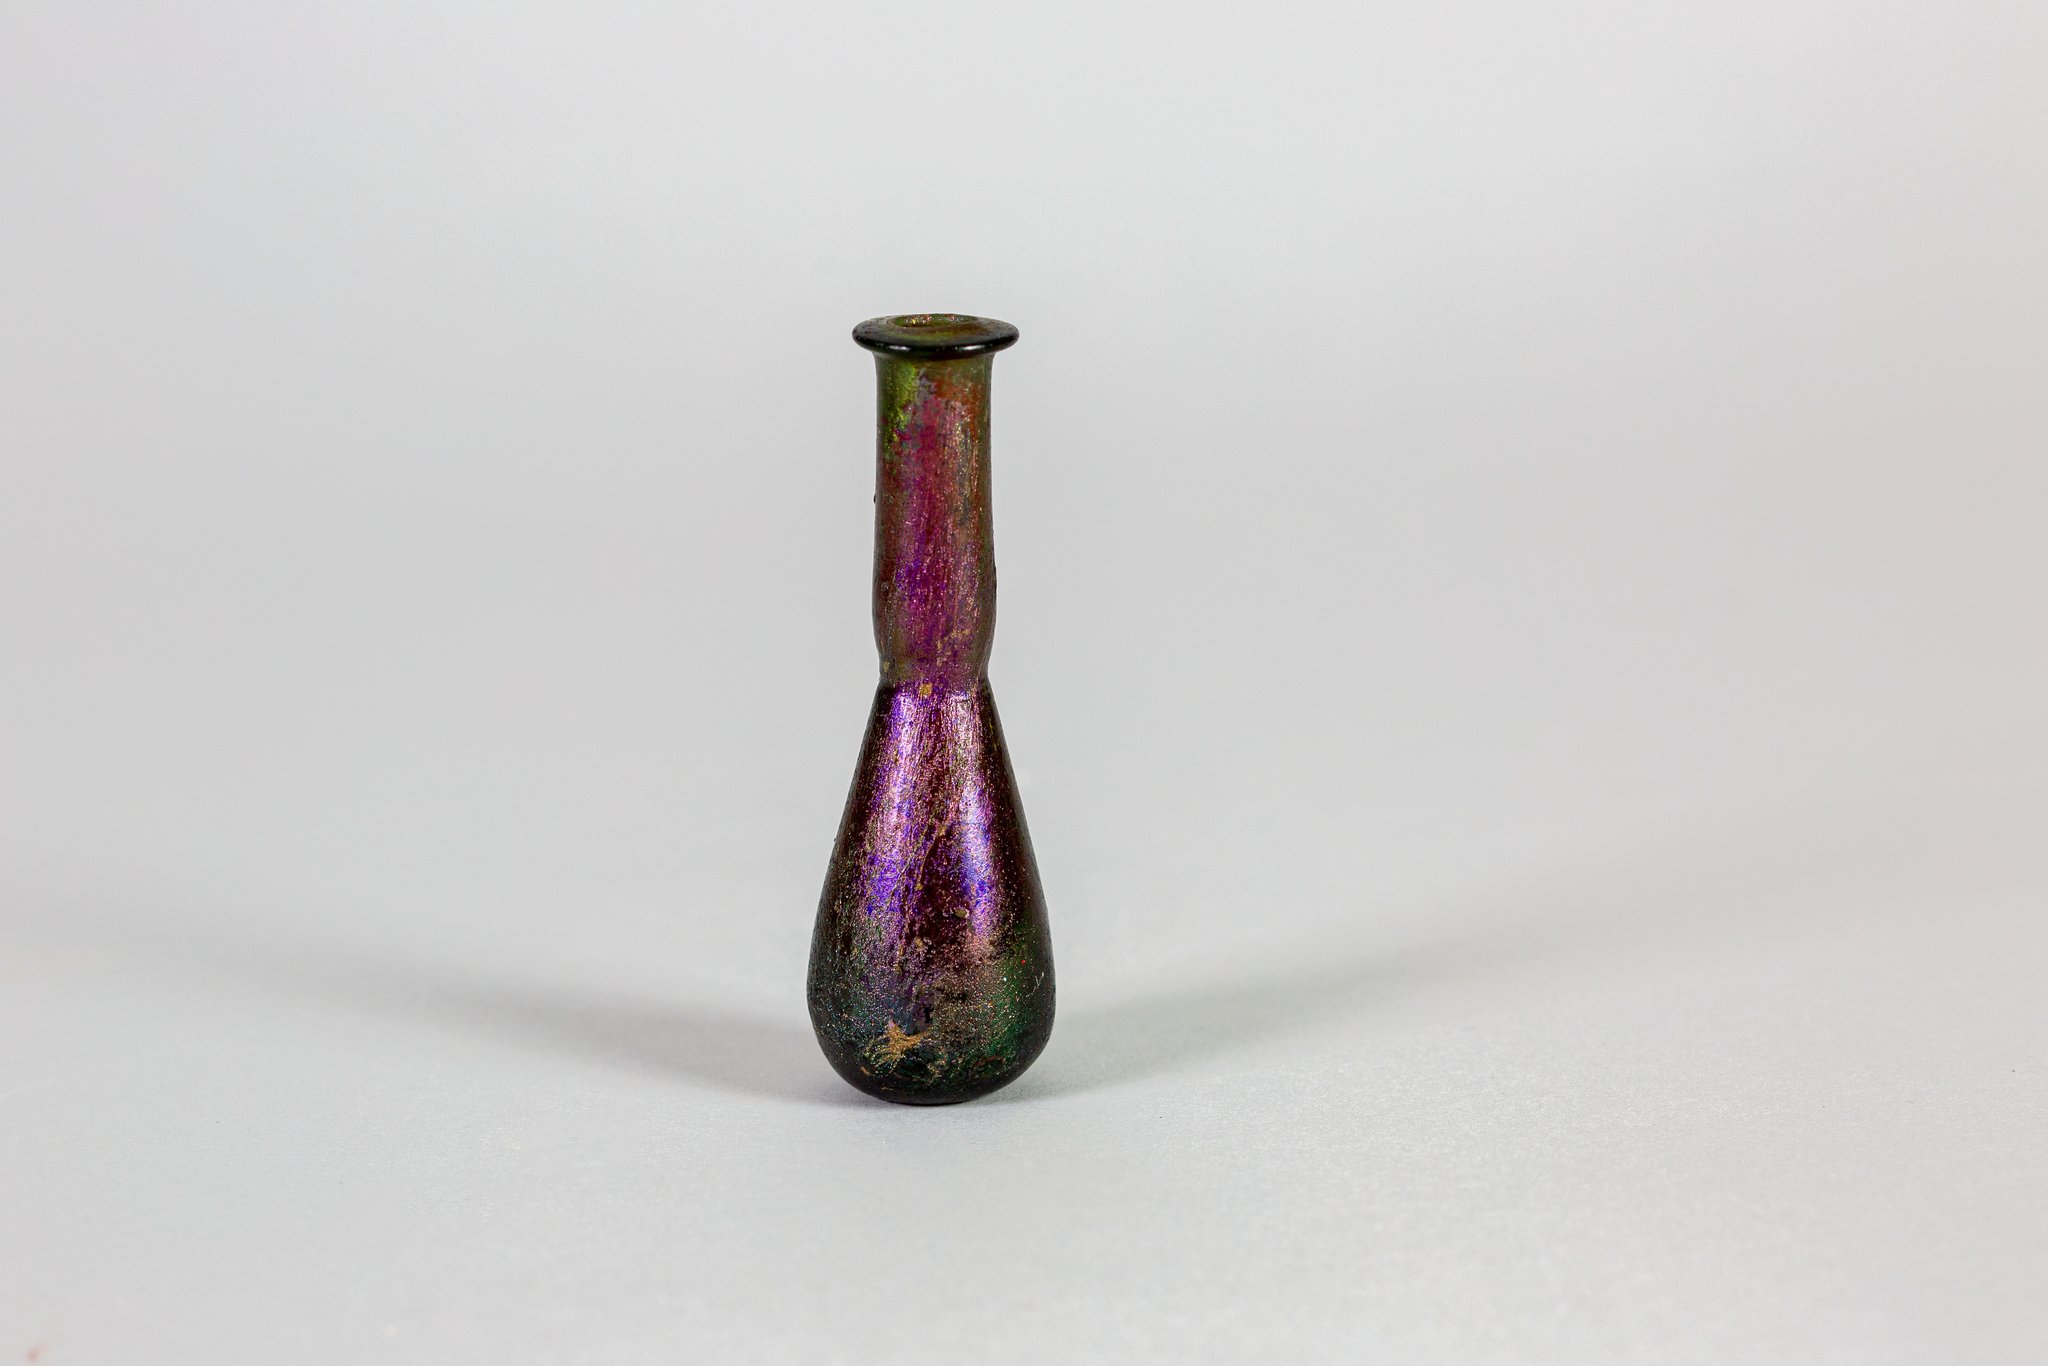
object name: perfume bottle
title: Glass perfume bottle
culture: roman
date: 1-133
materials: glass